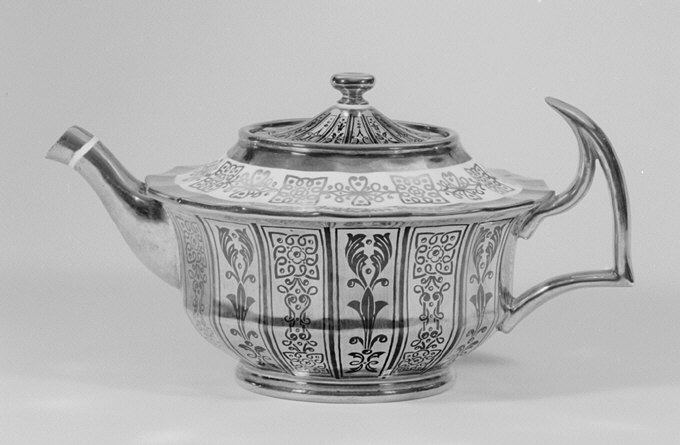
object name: teapot with cover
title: Teapot with cover (part of a tea service)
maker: imperial porcelain manufactory, st. petersburg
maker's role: manufactory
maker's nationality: russian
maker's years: 1744-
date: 1834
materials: hard paste porcelain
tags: flowers